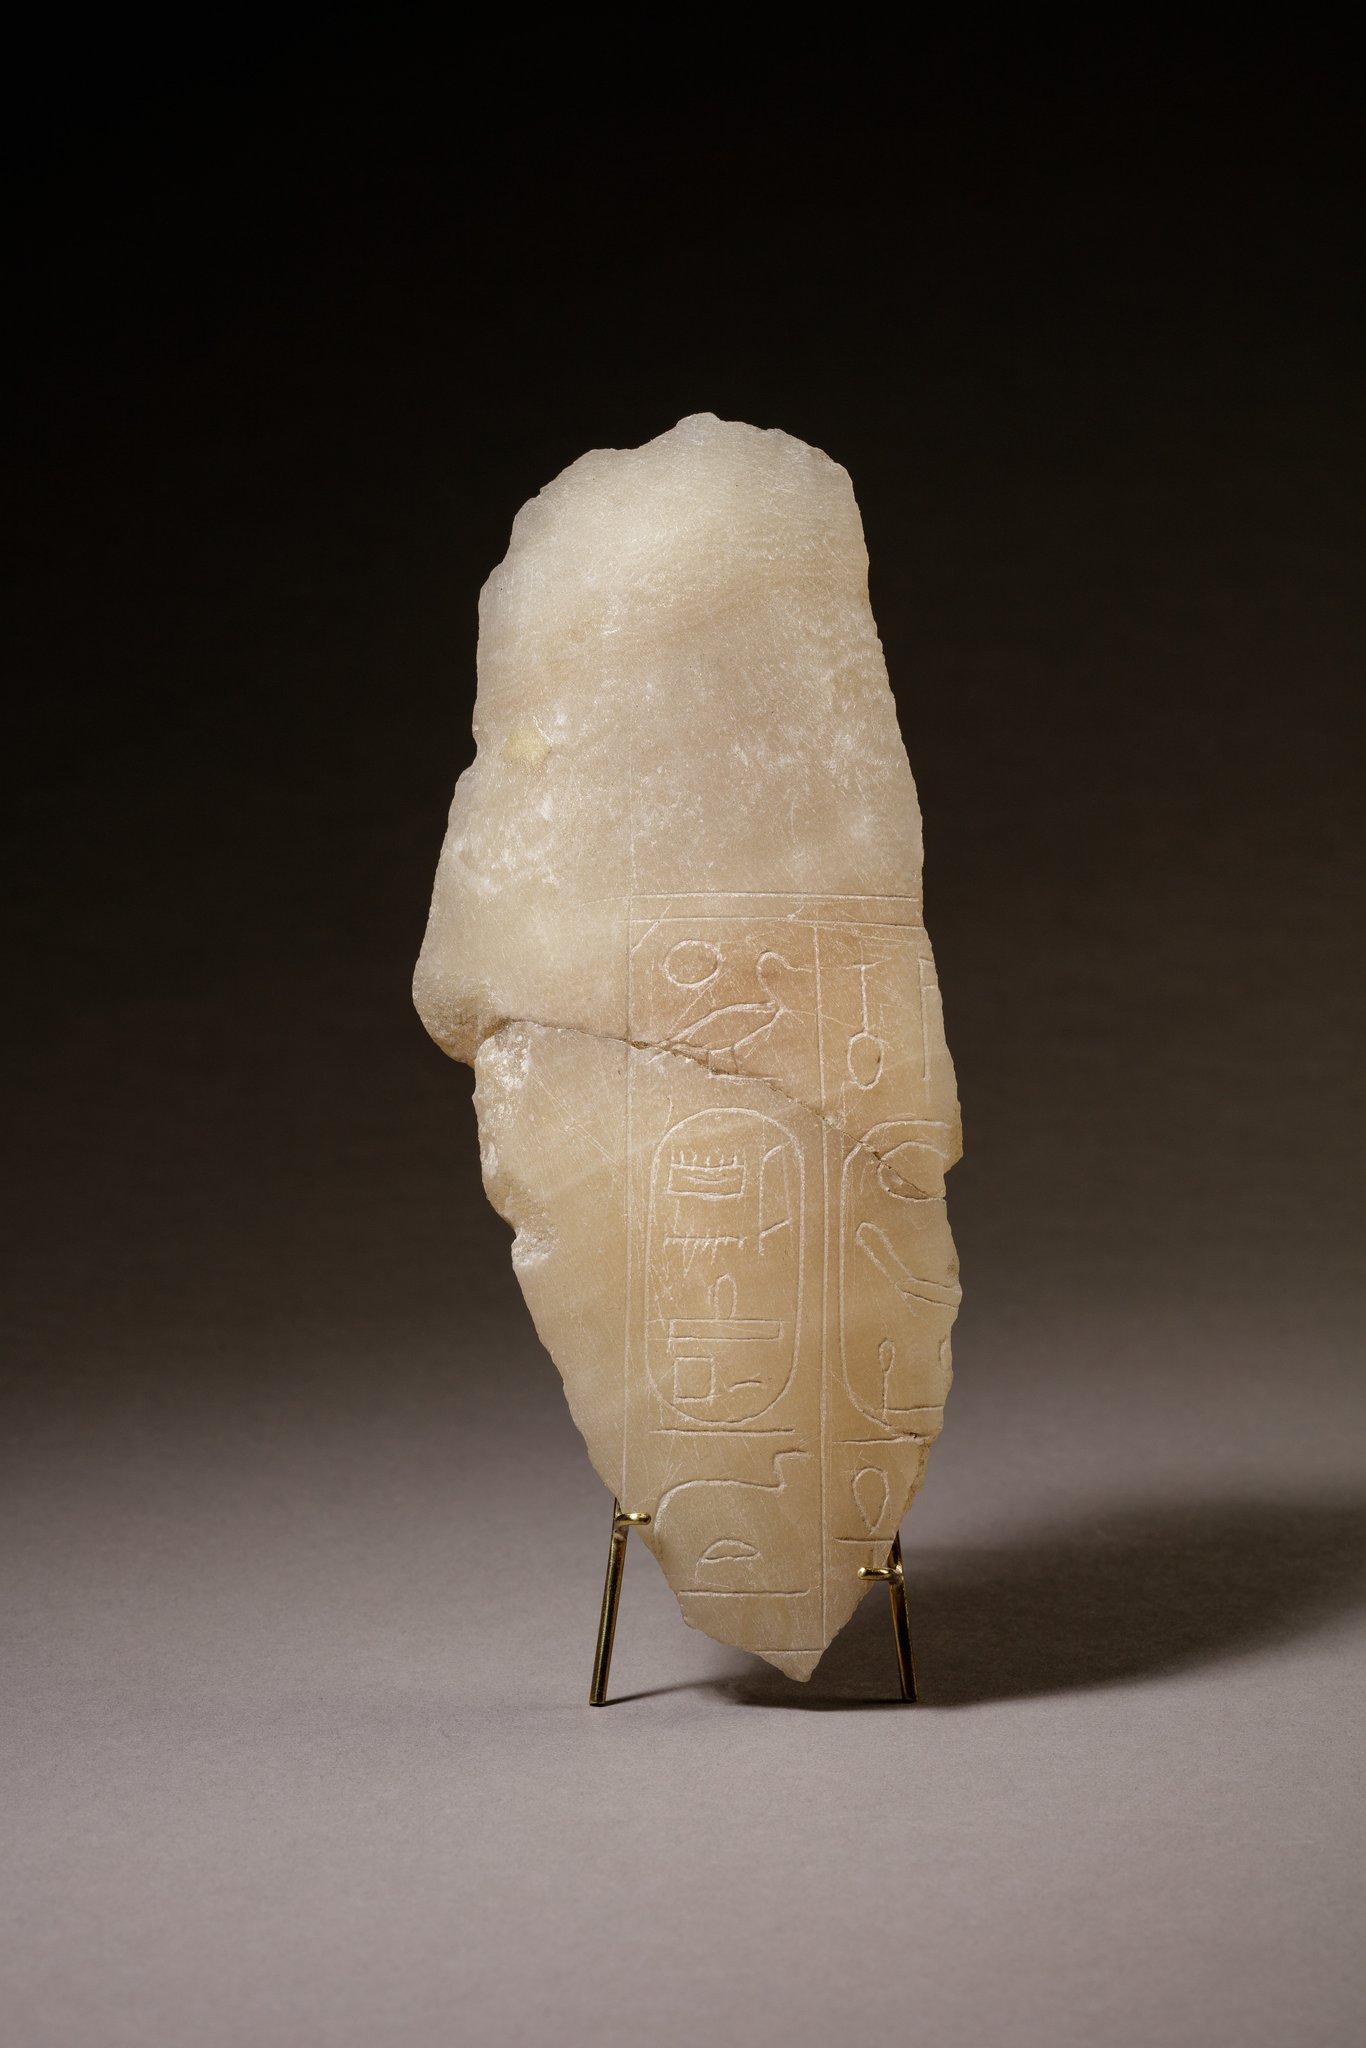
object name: jar fragment, cartouch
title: Jar fragment, cartouches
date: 1525-1504 BCE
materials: stone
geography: egypt